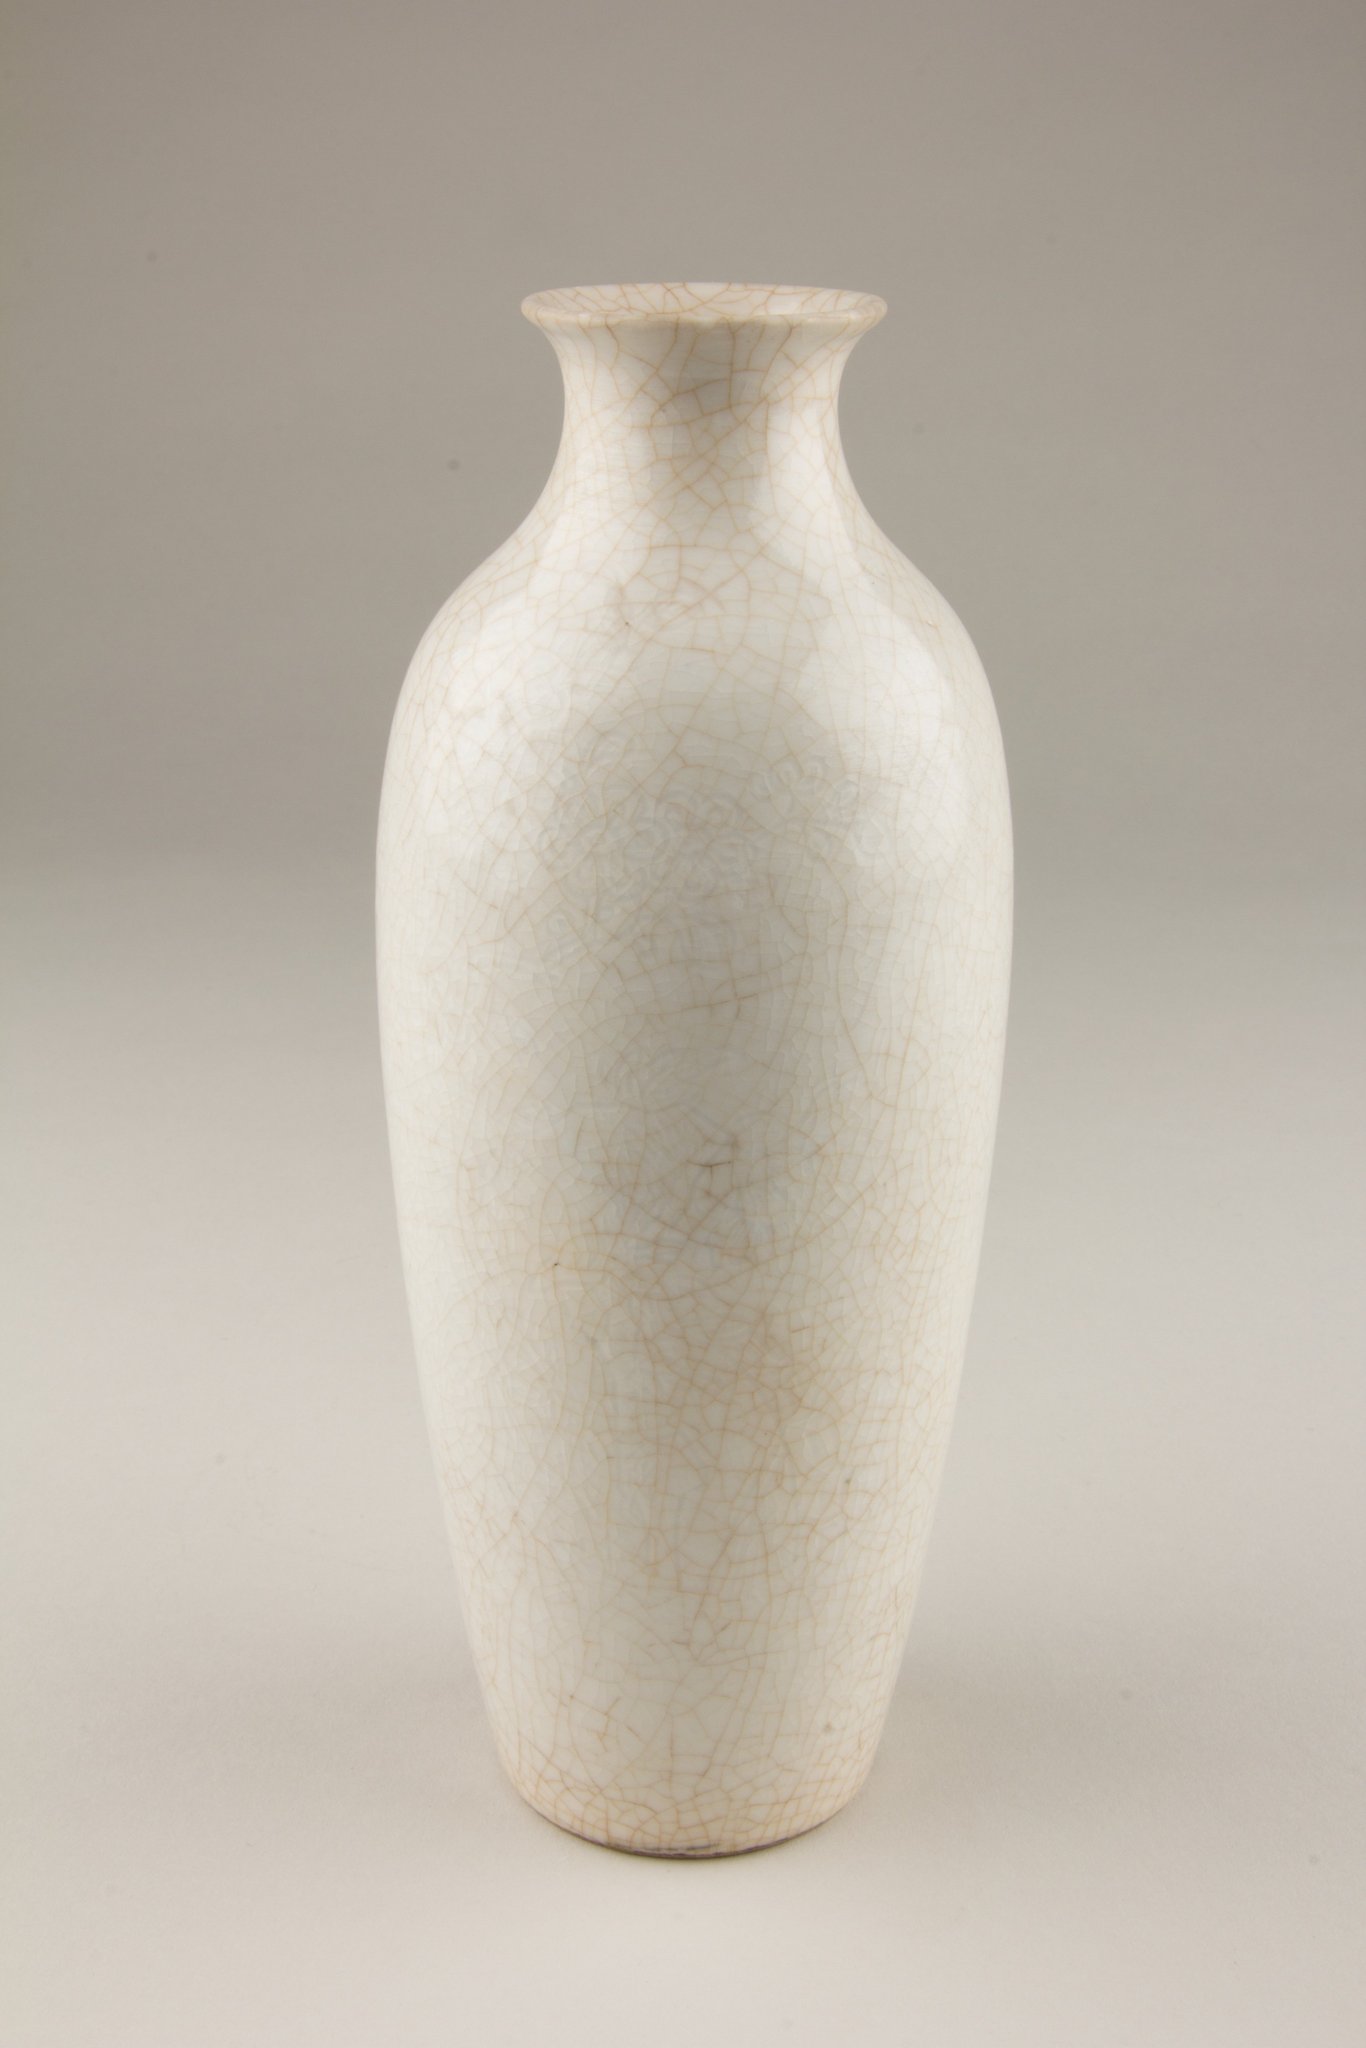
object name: vase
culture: chinese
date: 1736-1795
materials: porcelain